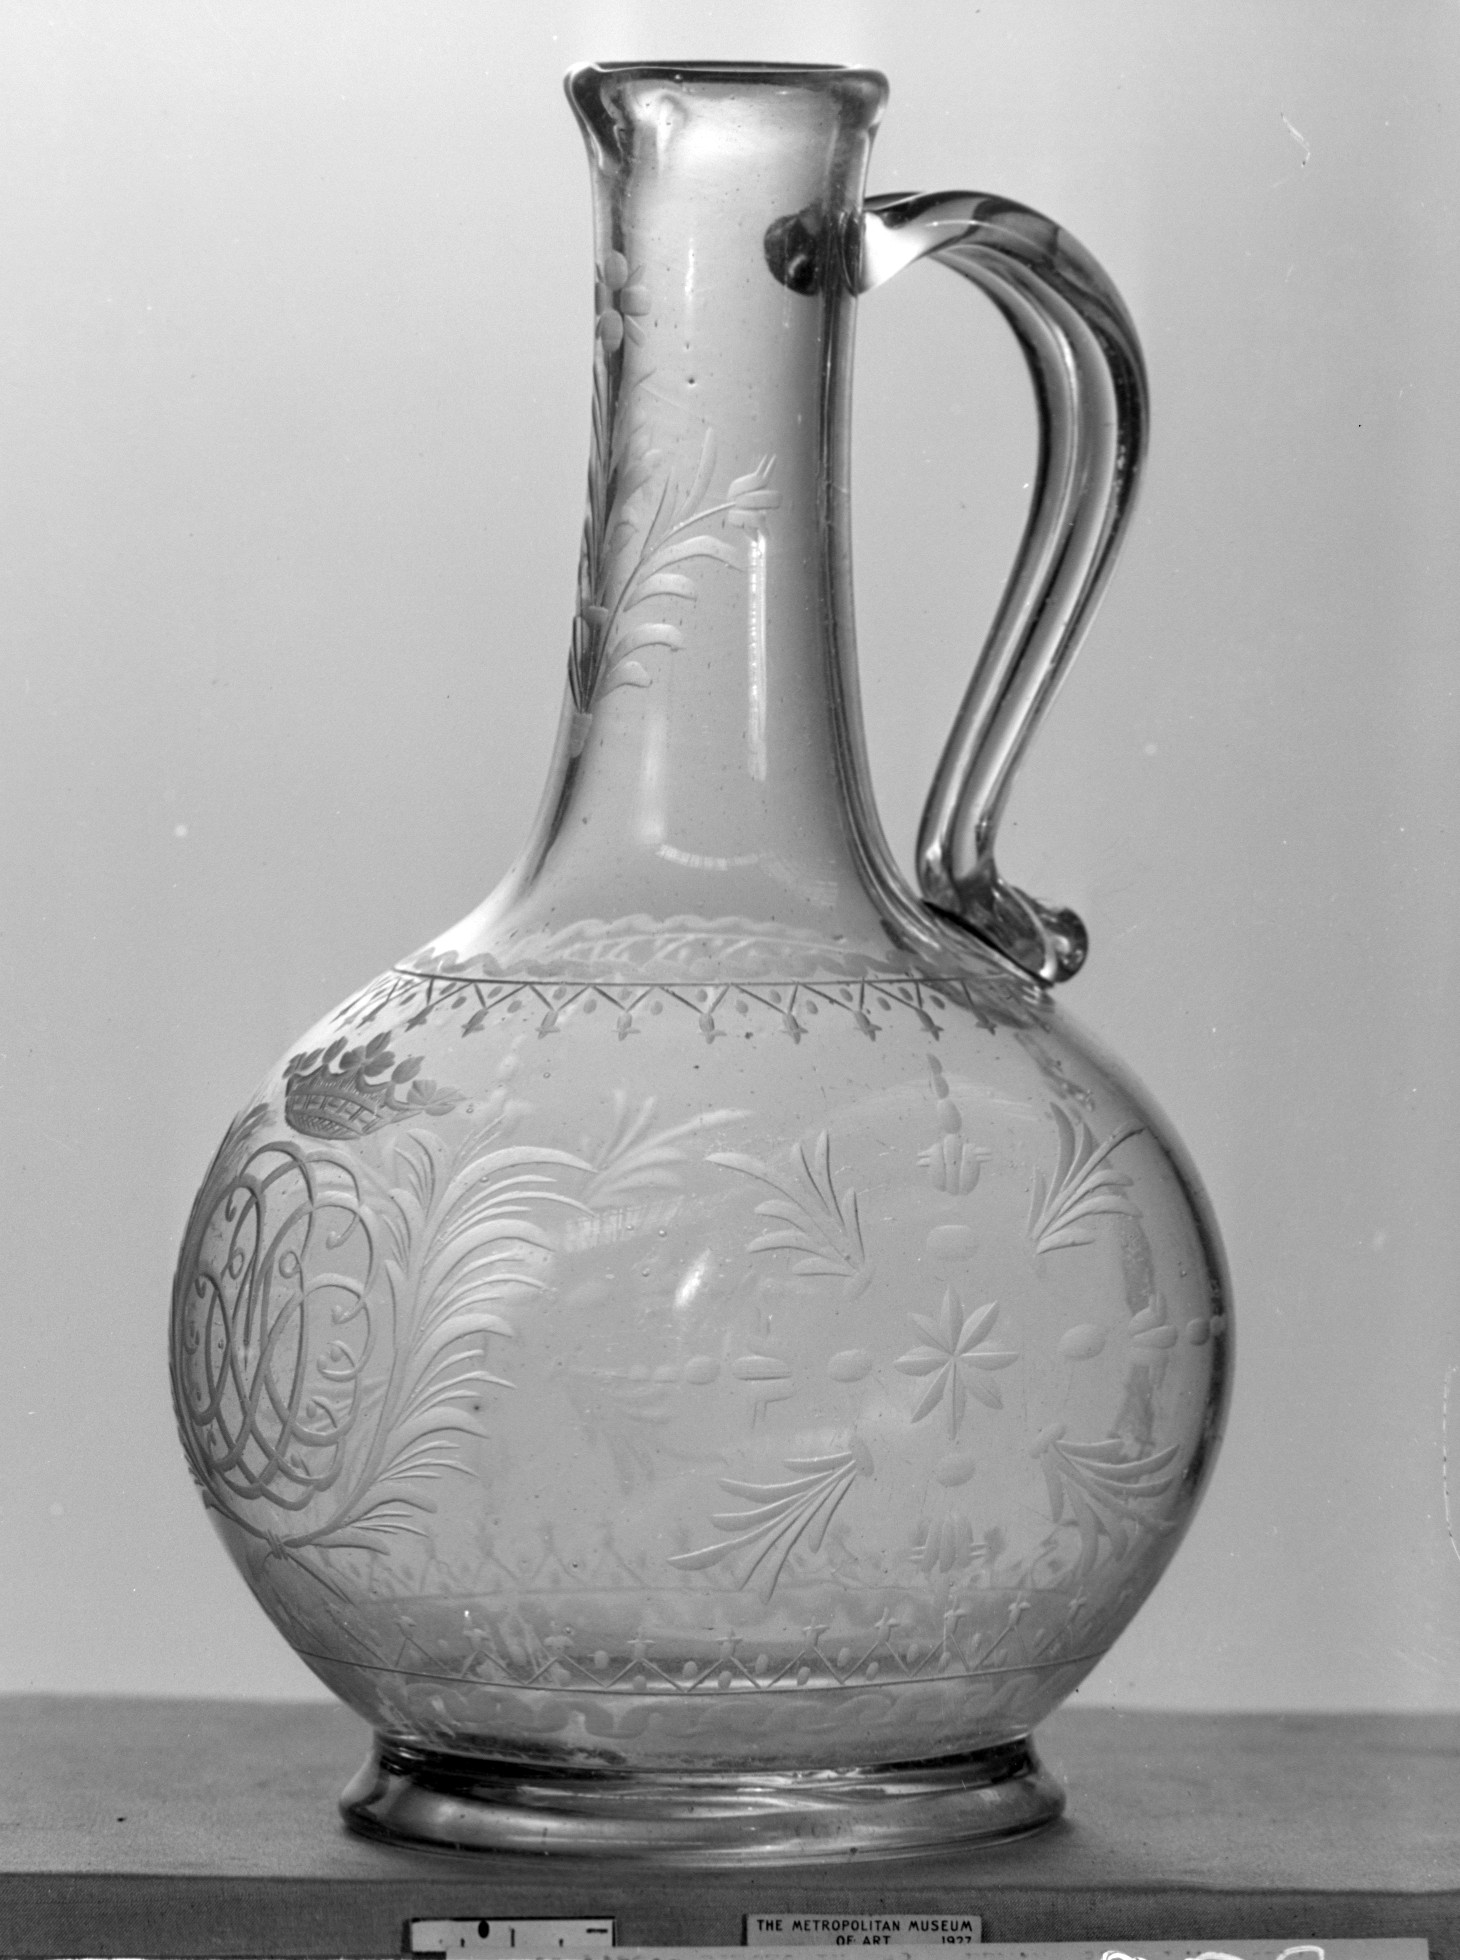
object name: ewer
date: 1701-1733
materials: glass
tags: flowers